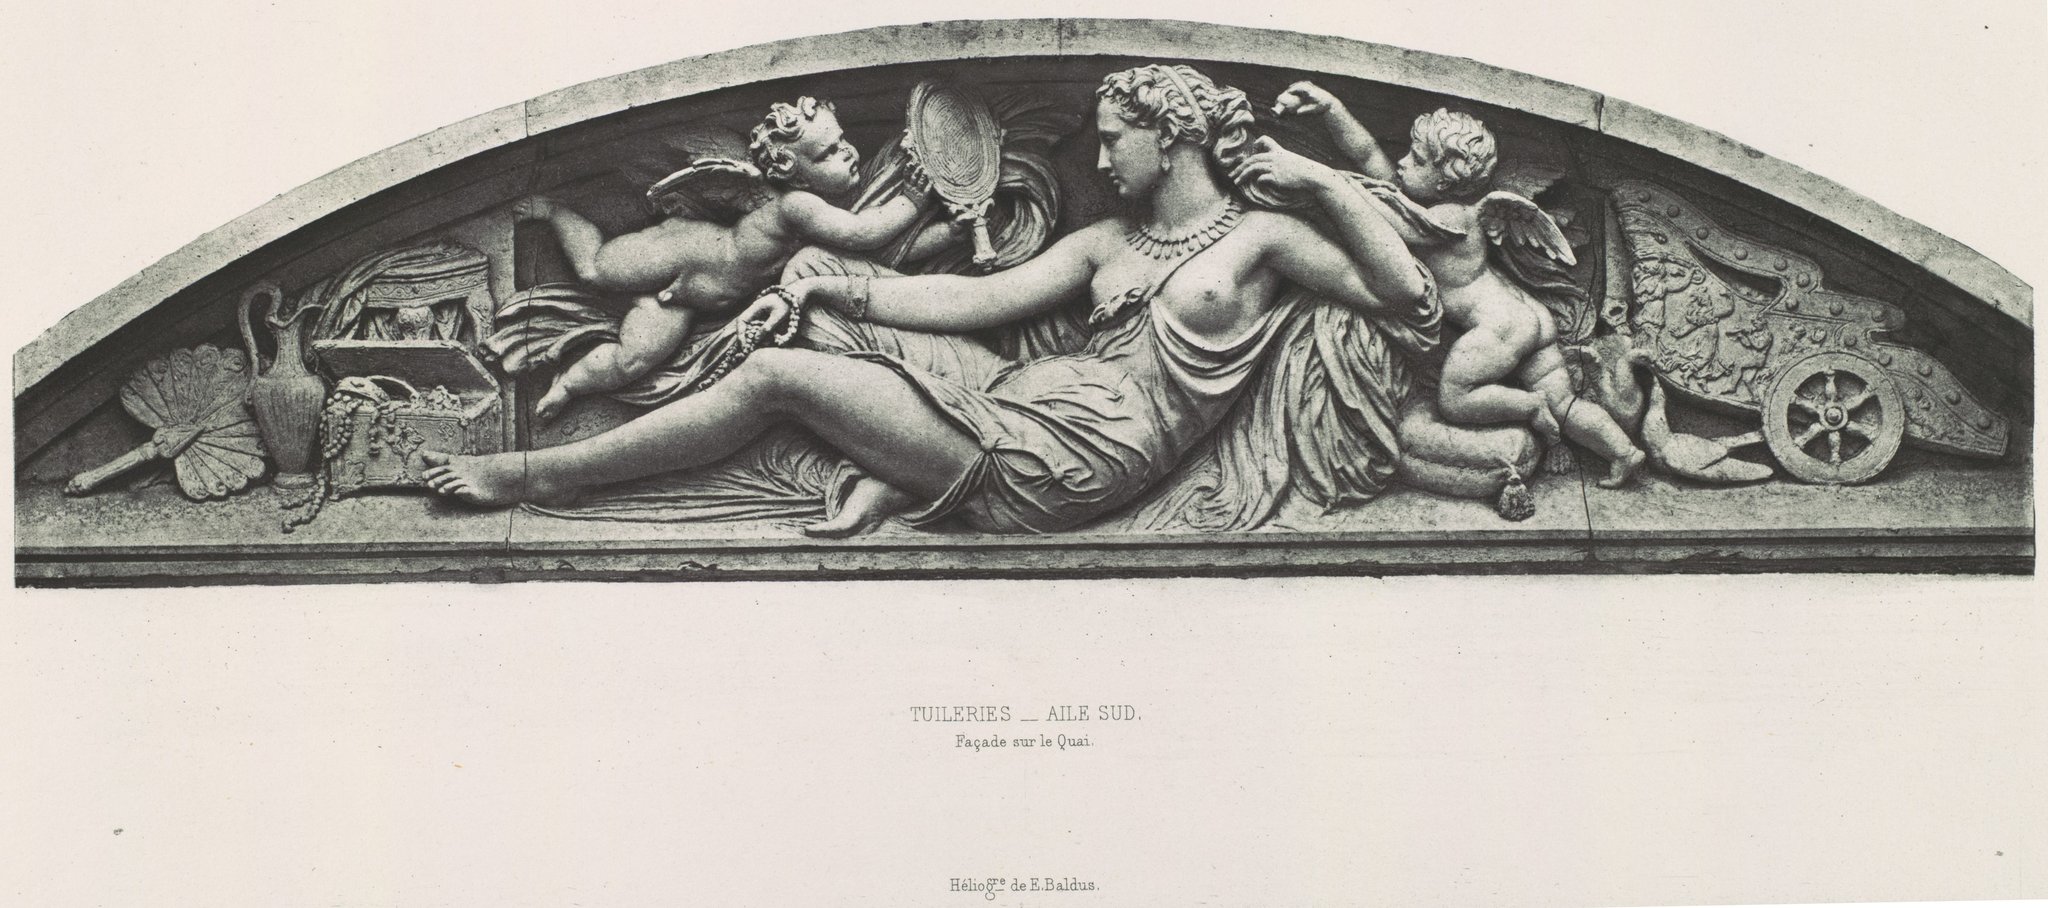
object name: photographically illustrated book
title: Palais du Louvre et des Tuileries, motifs de décorations tirés des constructions éxécutées au nouveau Louvre et au palais des Tuileries ..., tomes I / II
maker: édouard denis baldus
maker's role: fotograaf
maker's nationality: french, born prussia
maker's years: 1813-1889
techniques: photogravure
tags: female nudes,putti